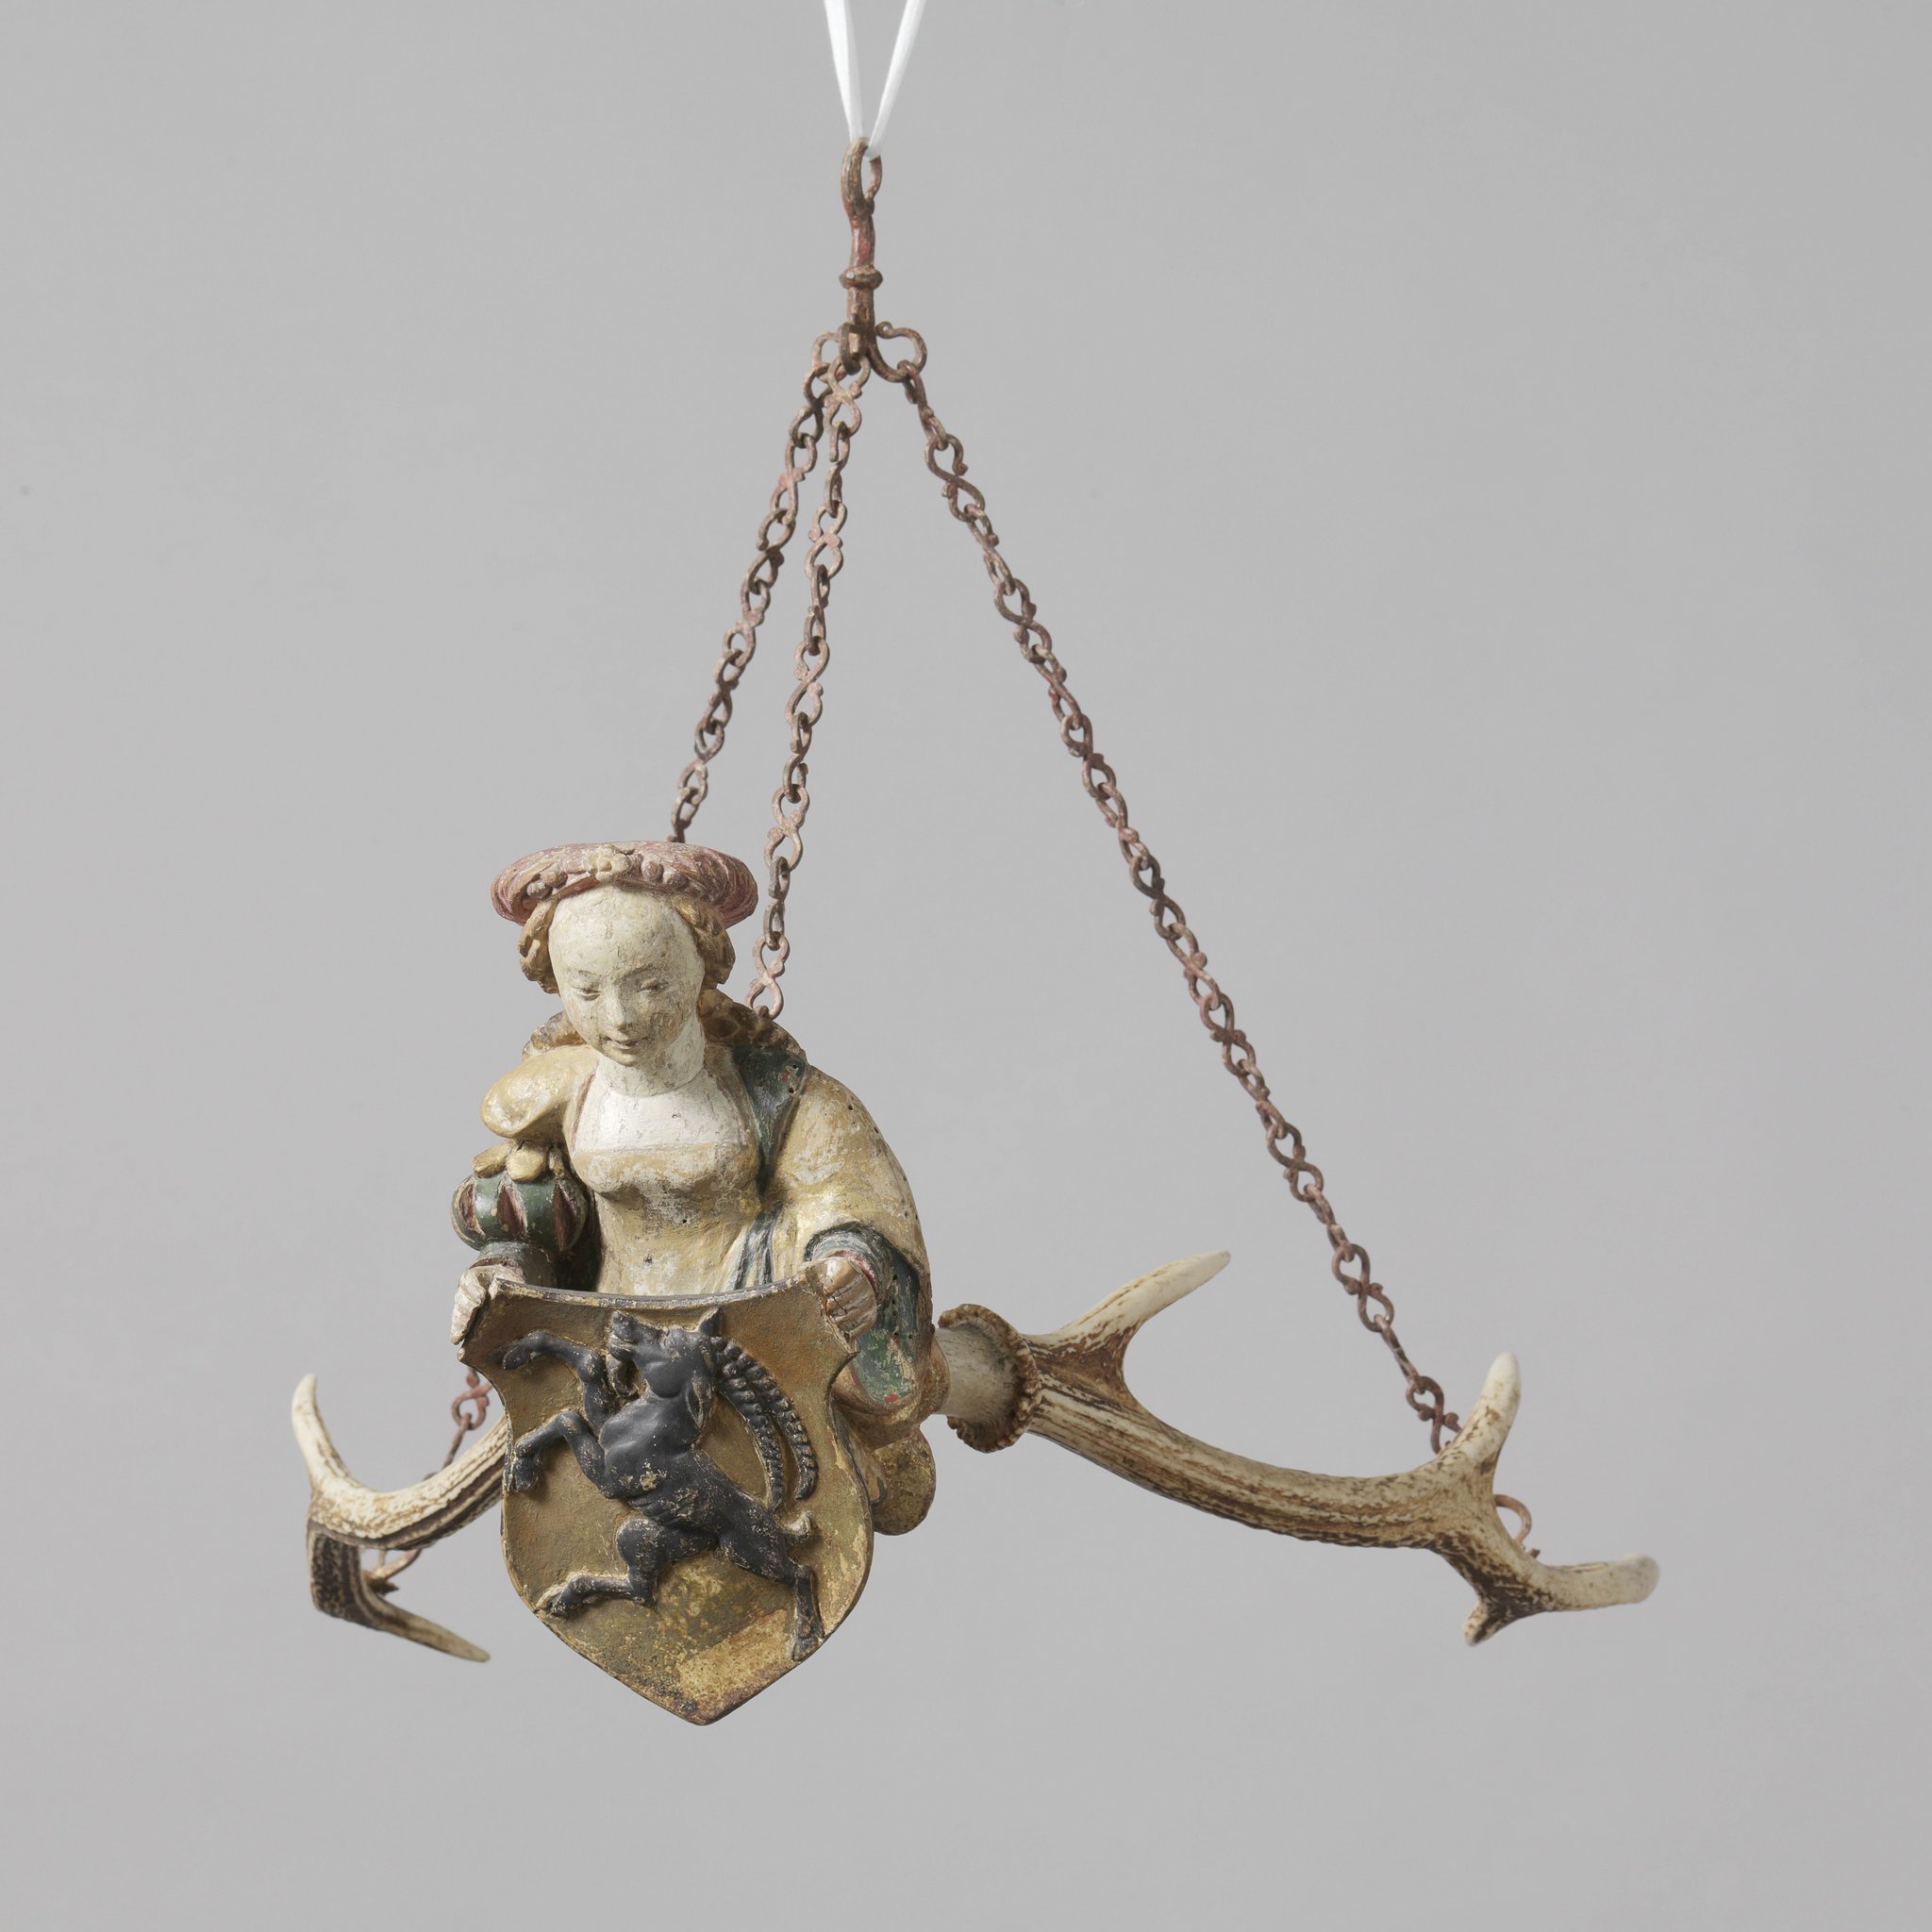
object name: sculpture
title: Antler Chandelier with Female Figure (‘Leuchterweibchen’)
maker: Anonymous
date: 1525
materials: iron, wood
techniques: polychromy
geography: mechelen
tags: armorial bearing, heraldry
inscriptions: coat of arms, on the escutcheon in the figure's hands, in relief: an ibex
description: The meaning of the curious combination of a woman with a coat of arms and a suspended deer antler are not clear. Such objects were found in town halls and thus must have had an official significance. They owe their German name Leuchterweibchen (chandelier woman) to the custom of sticking candles onto the antler points.